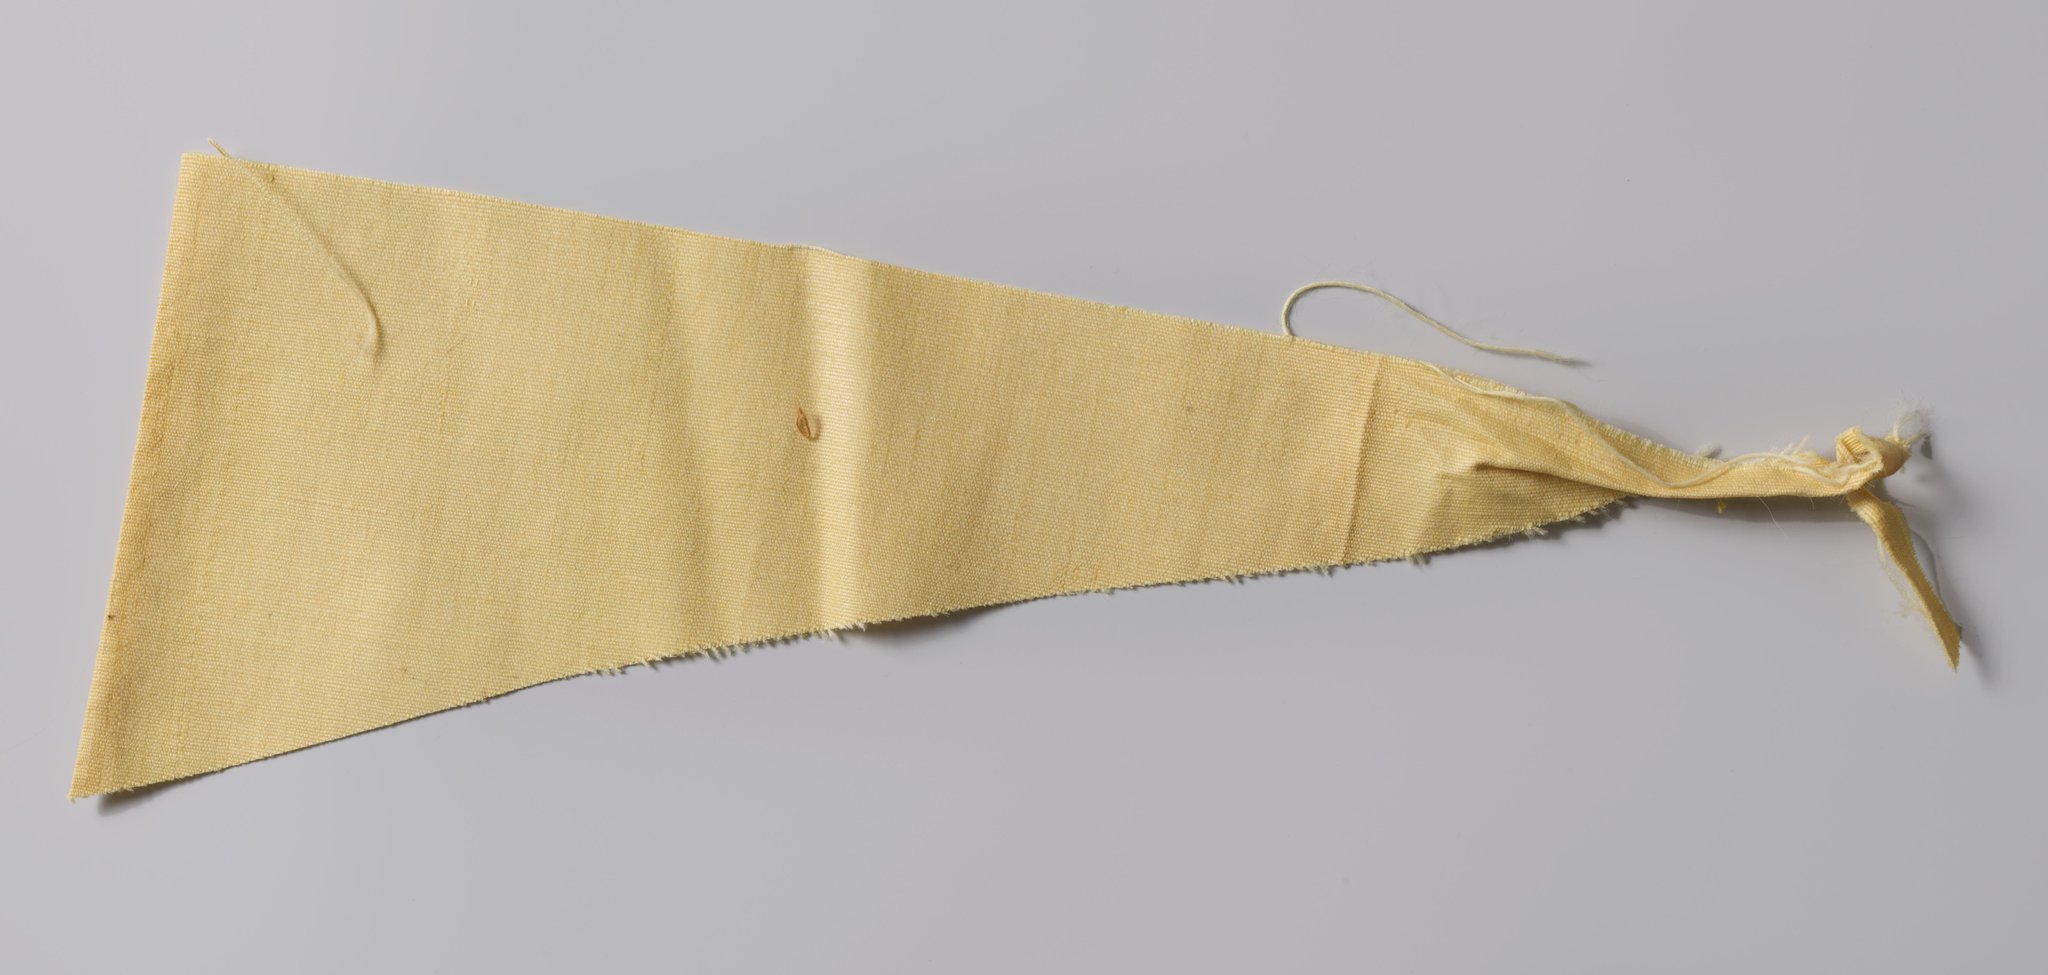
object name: fragment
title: Fragment van een bedgarnituur van gele gewaterde wol met groen passement en afhangende klosjes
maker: Anonymous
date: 1795-1815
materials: wool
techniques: moire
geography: northern netherlands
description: Fragment van een bedgarnituur van gele gewaterde wol, omboord met groen passement met een geel motief en met een groen en geel boordsel met afhangende klosjes die met gele en groene zijde zijn omwonden.